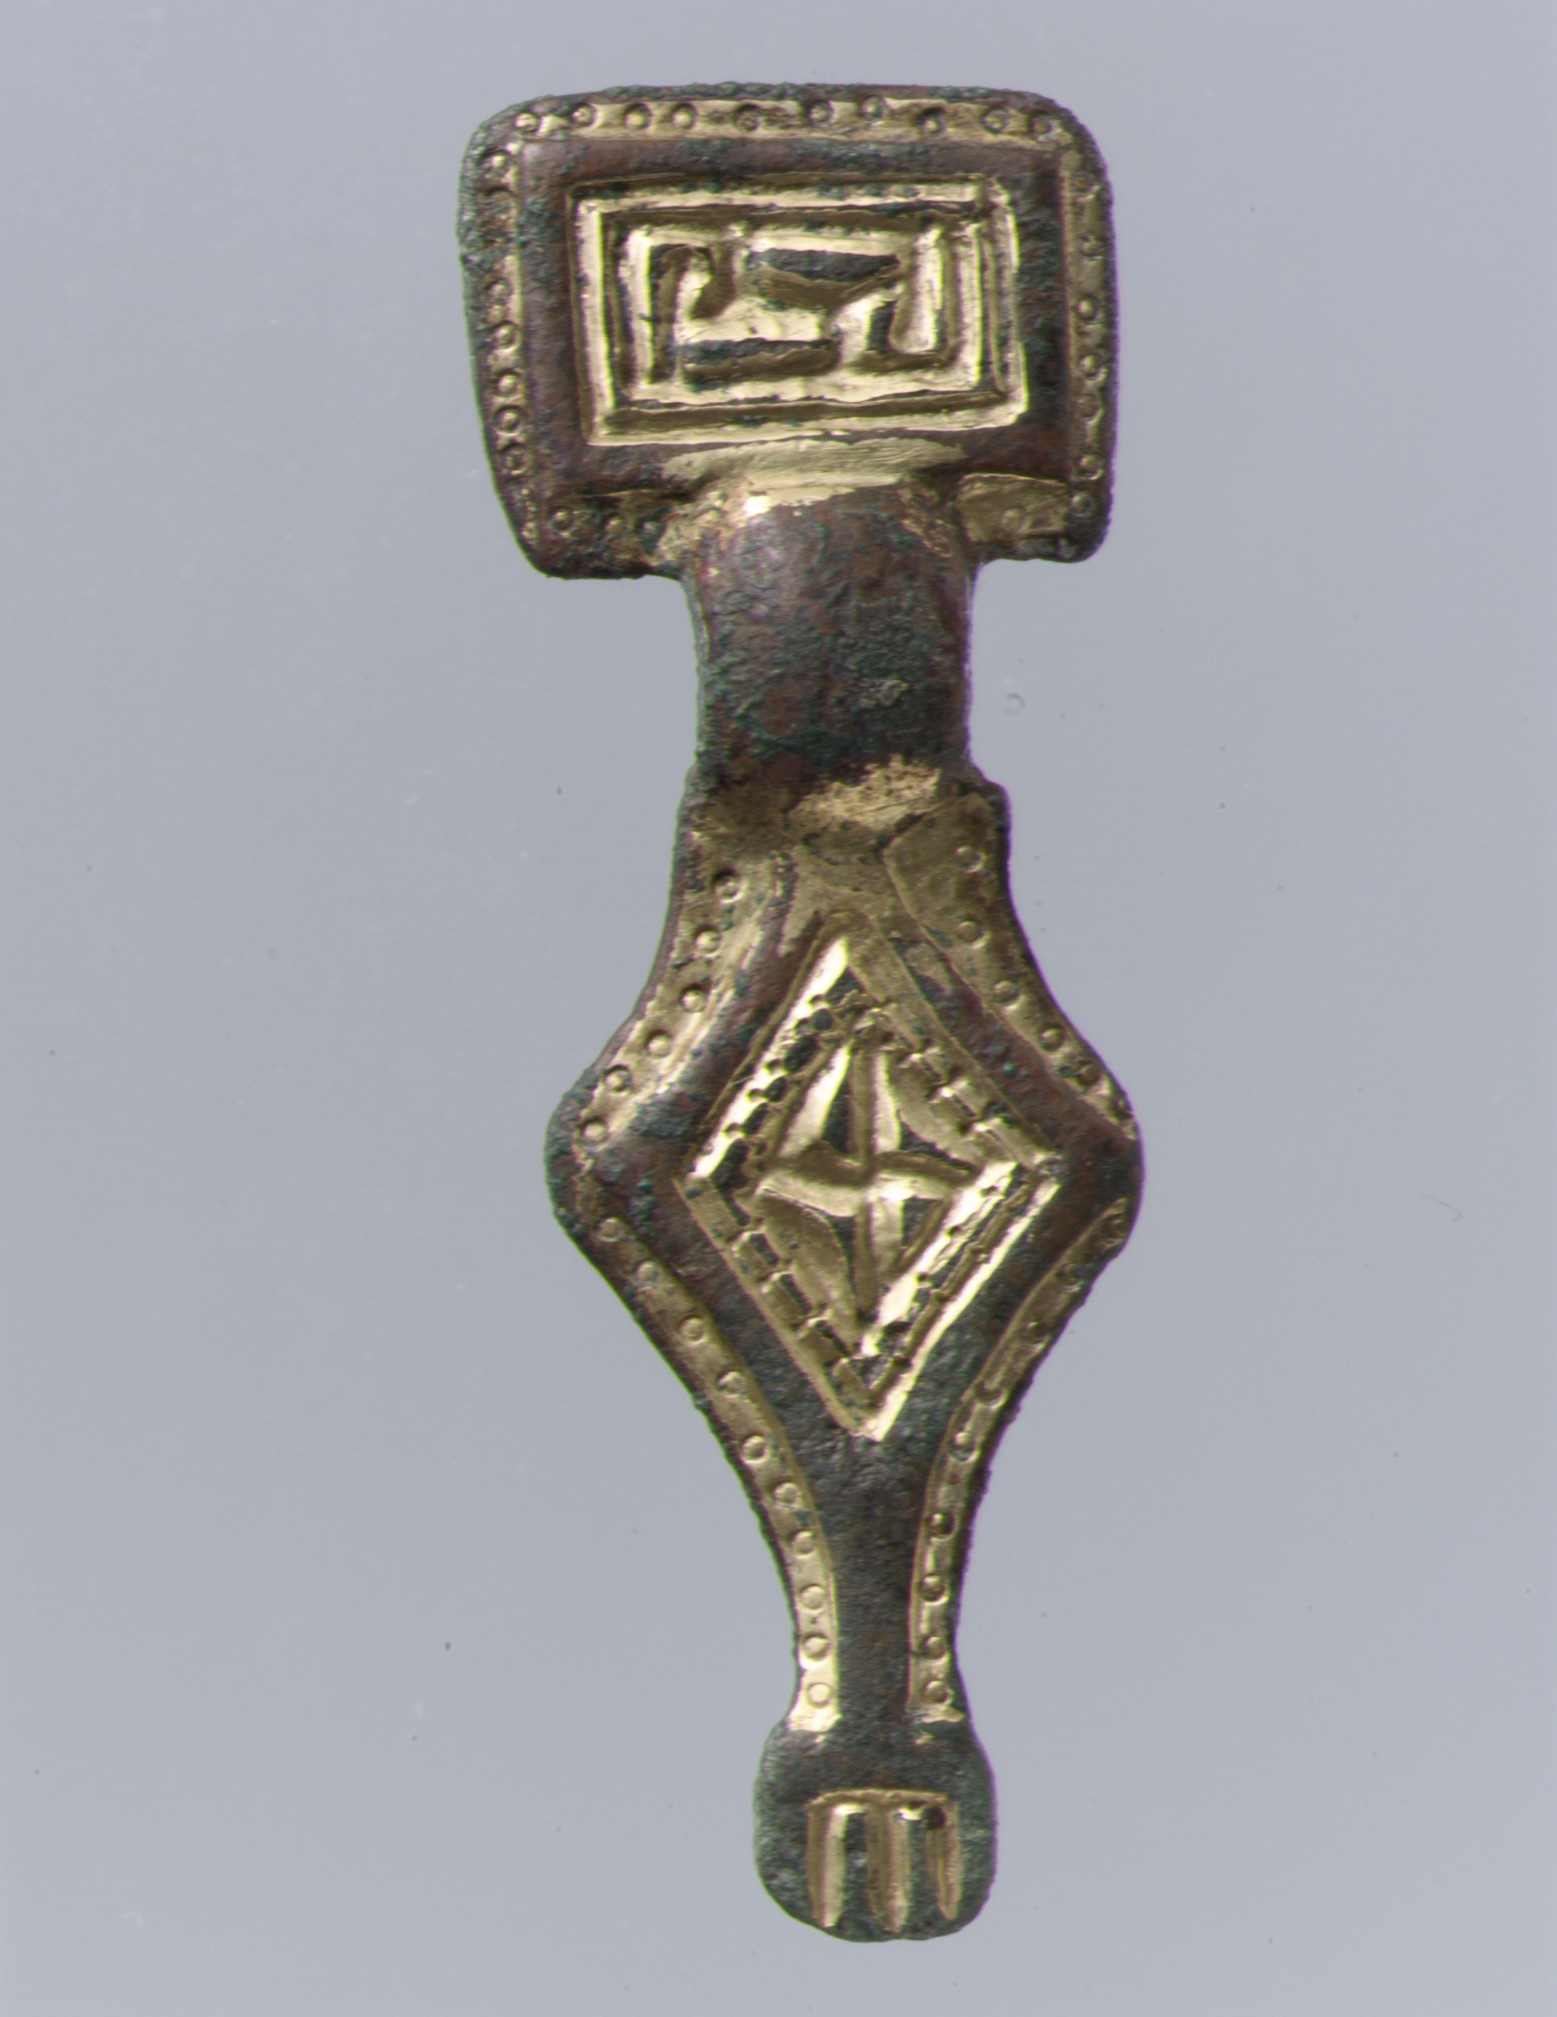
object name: brooch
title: Miniature Square-Headed Brooch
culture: anglo-saxon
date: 500-550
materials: iron, silver gilt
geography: england